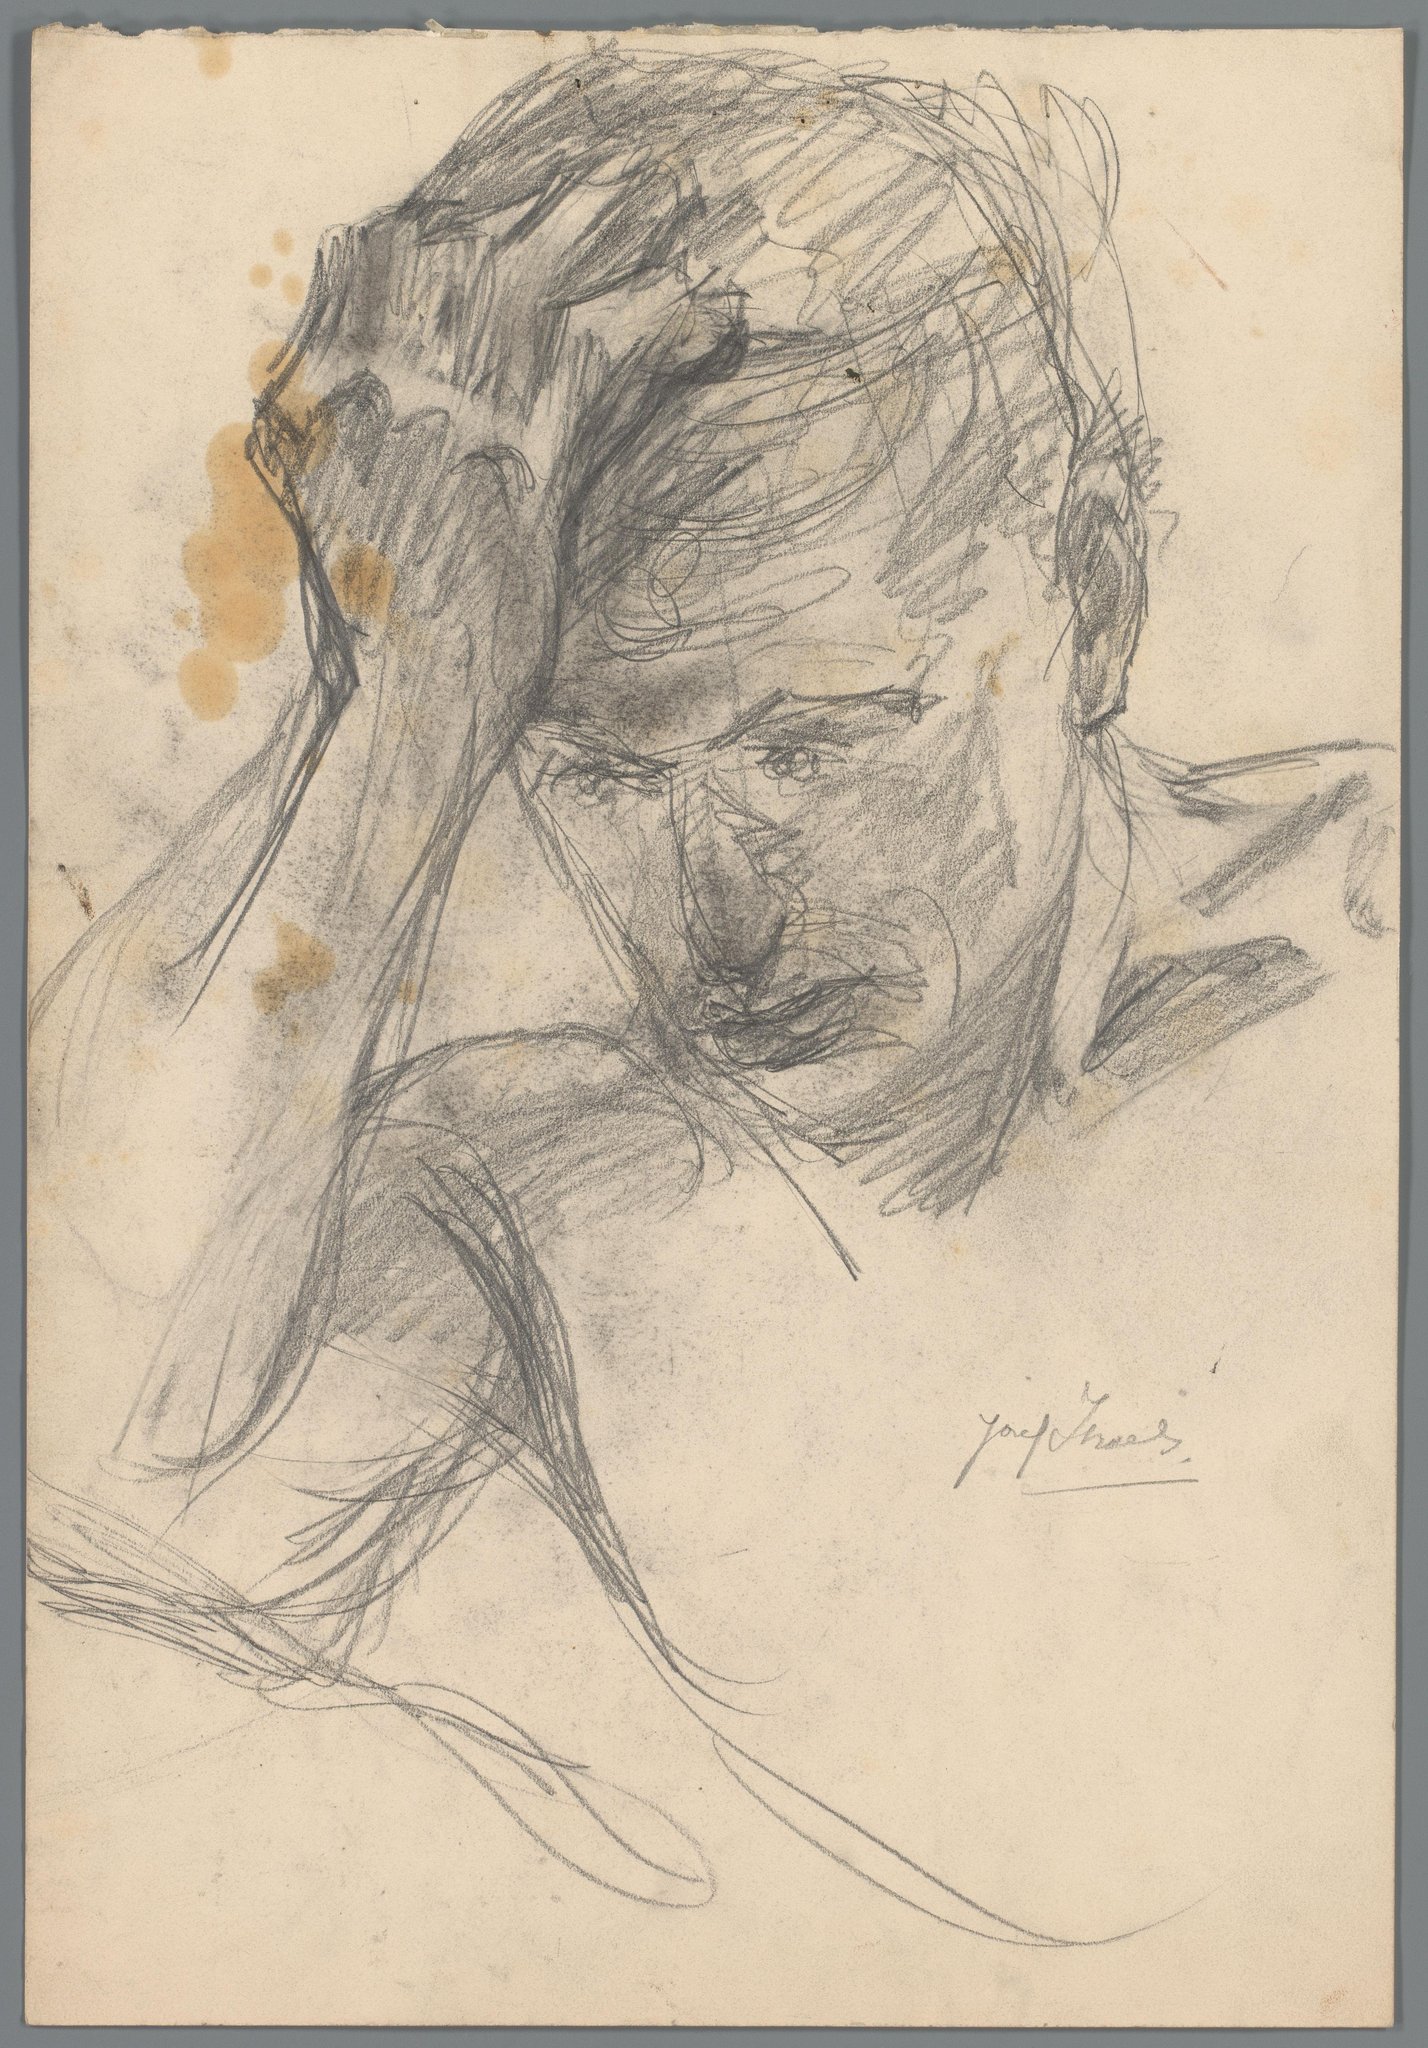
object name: drawing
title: Hoofd van Saul met de rechterhand tegen het voorhoofd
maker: jozef israëls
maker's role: draughtsman, painter, print maker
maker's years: 1824-1911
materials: paper, pencil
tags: head (human), hand towards the forehead, story of saul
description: Voorstudie voor het schilderij 'David en Saul' dat zich in het Groninger Museum bevindt.